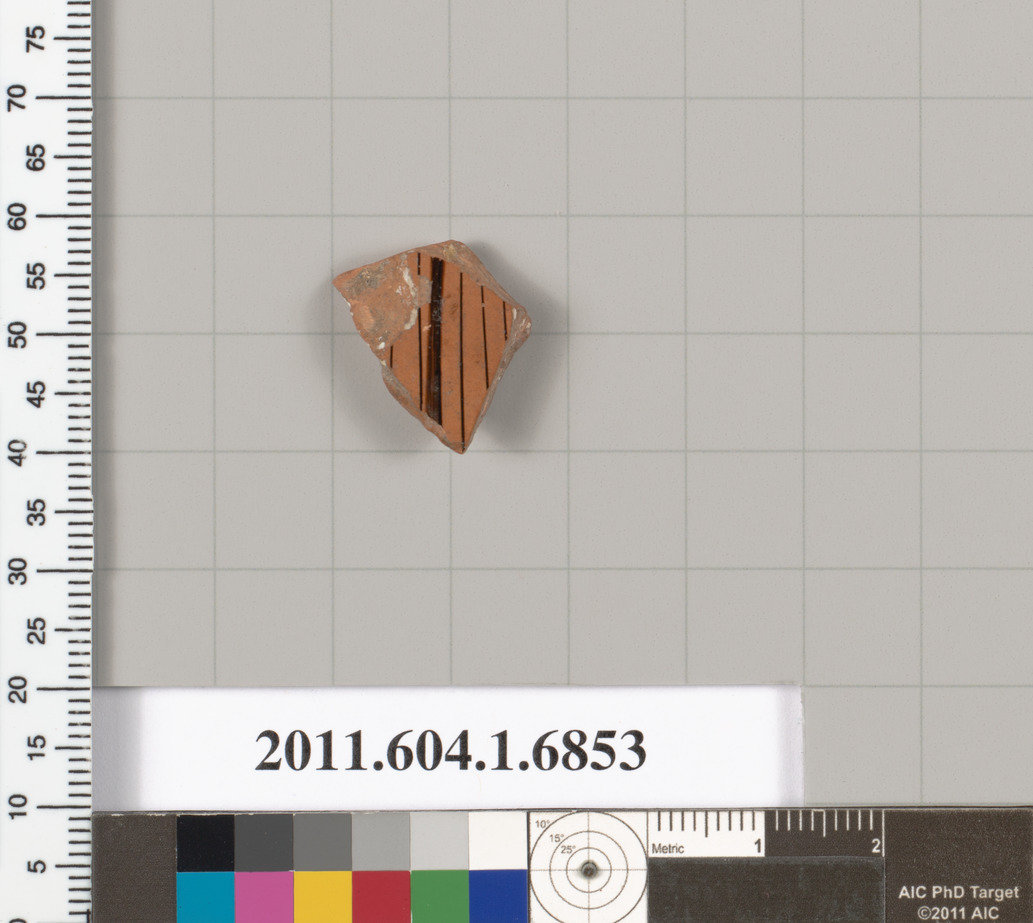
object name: kylix fragment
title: Terracotta fragment of a kylix (drinking cup)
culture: greek, attic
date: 490-470 BCE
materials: terracotta